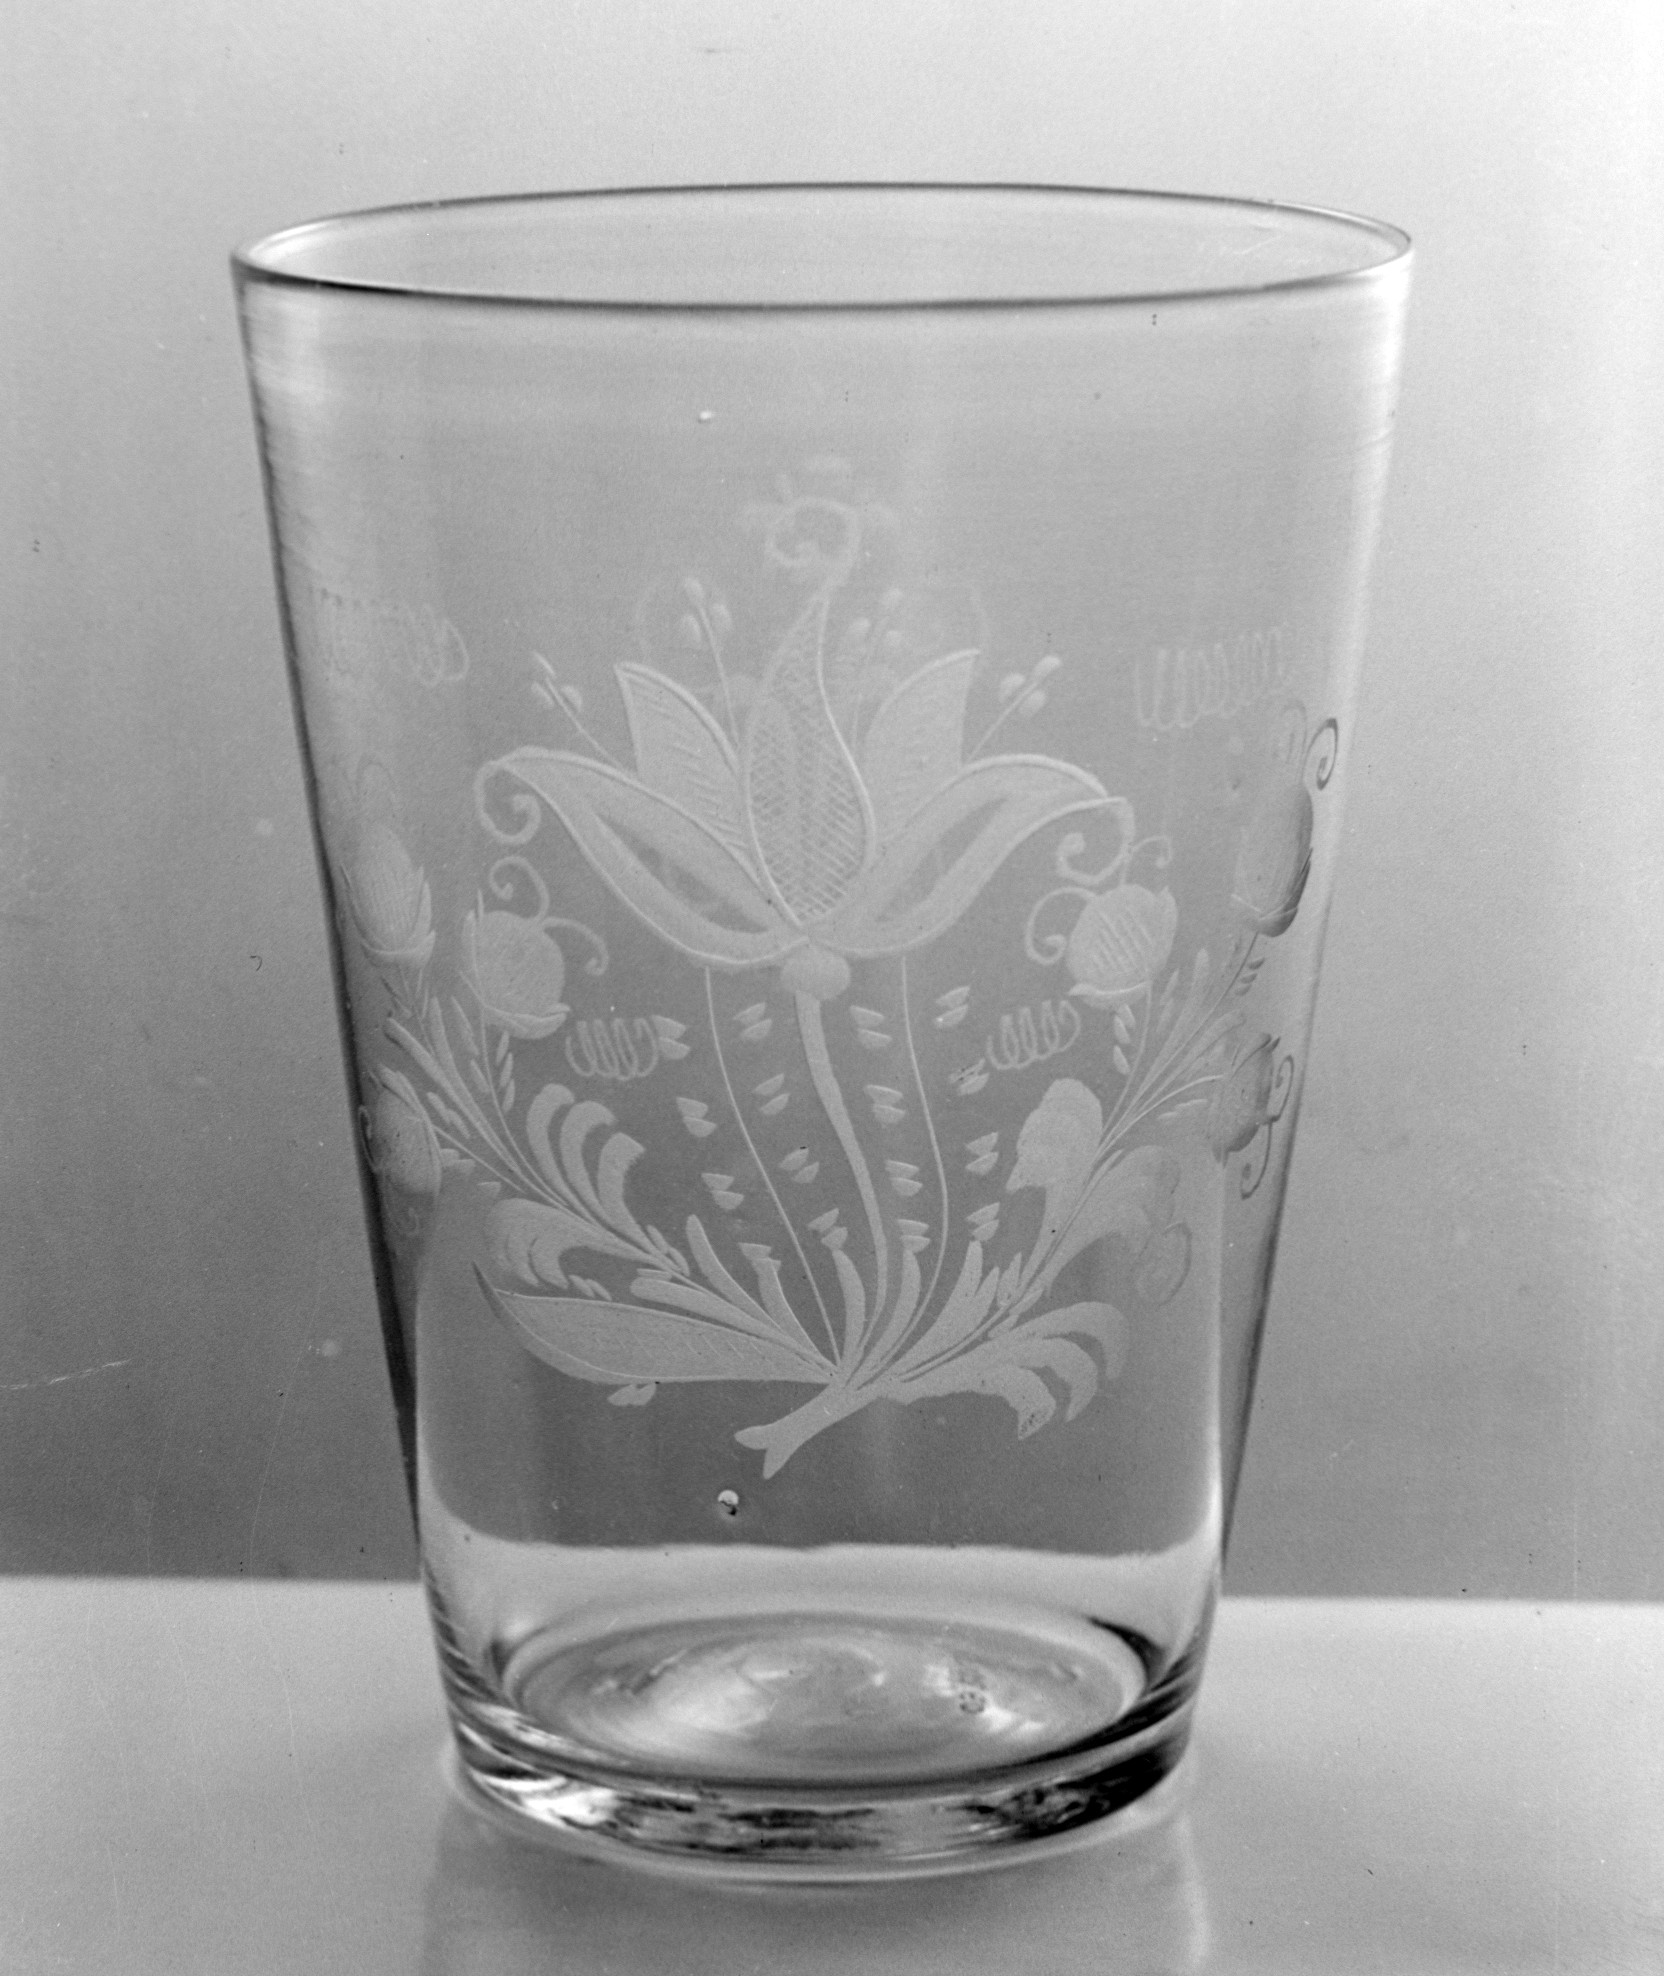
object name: flip or toddy glass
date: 1701-1800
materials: glass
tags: flowers